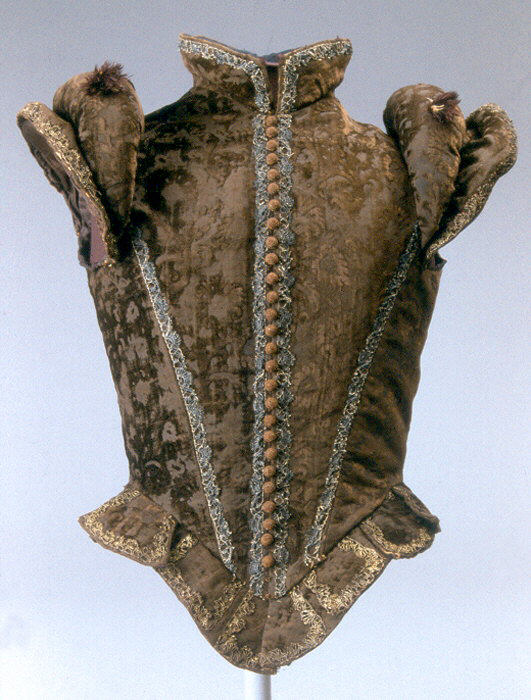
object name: jerkin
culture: european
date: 1570-1580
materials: metal thread, silk